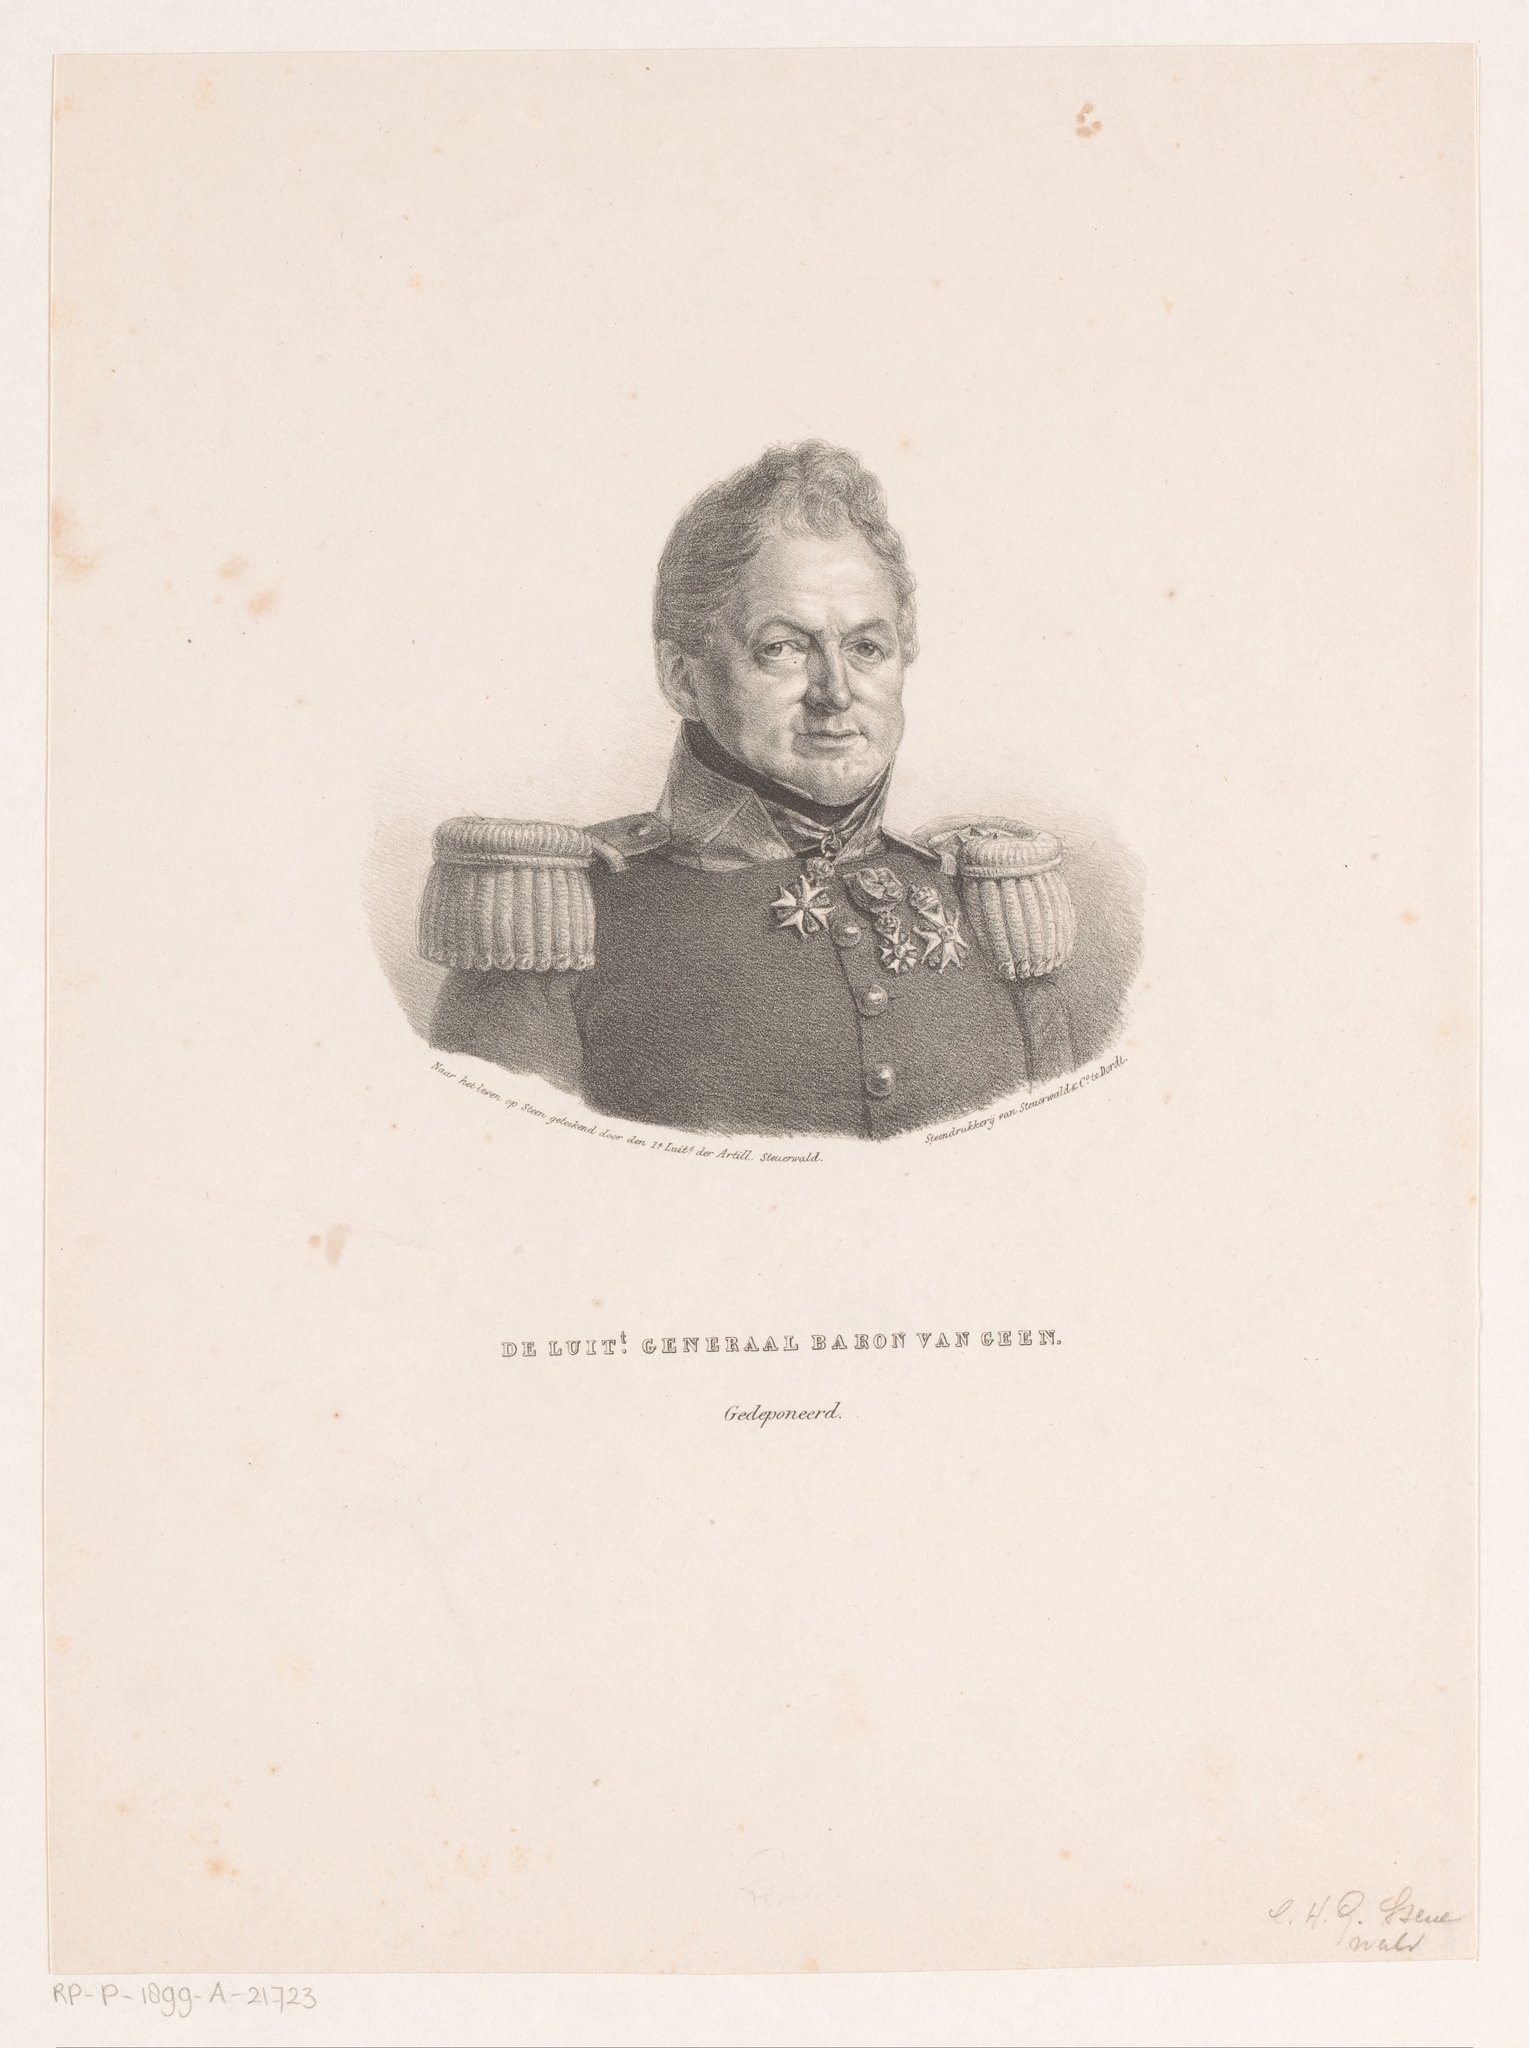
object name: print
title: De luitt. generaal baron Van Geen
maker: christian heinrich gottlieb steuerwald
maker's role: draughtsman, print maker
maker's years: 1802-1874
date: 1826-1833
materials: paper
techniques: lithograph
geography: dordrecht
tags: ghent, historical persons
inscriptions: : ‘Gedeponeerd.’, collector's mark: Lugt 2228